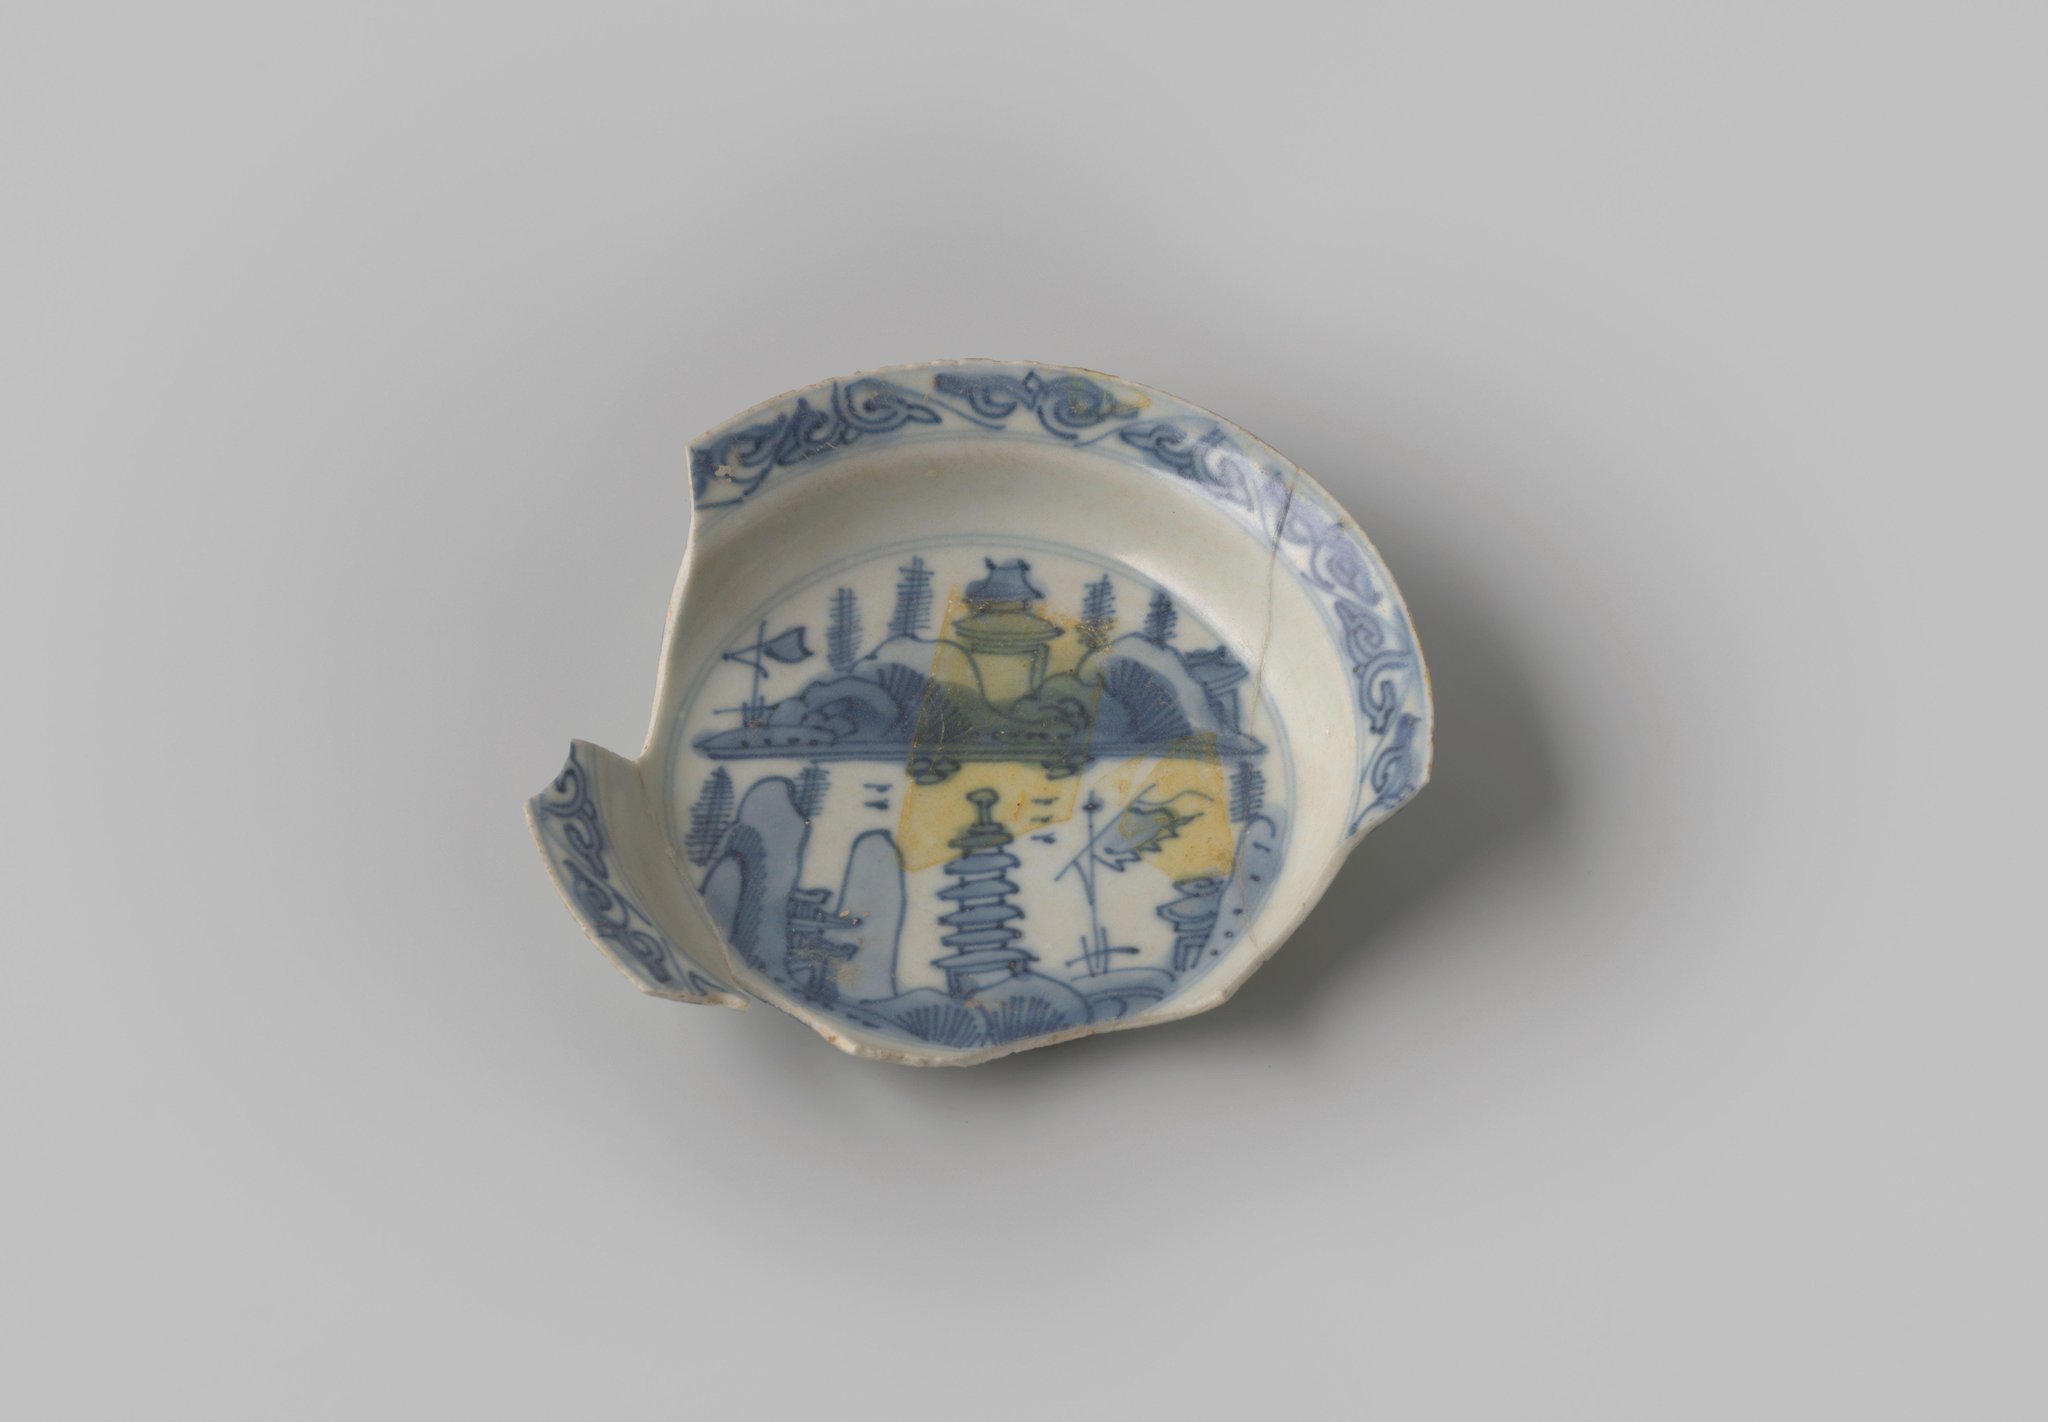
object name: platter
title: Schotel uit V.O.C.-schip de 'Witte Leeuw'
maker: Anonymous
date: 1613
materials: porcelain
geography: jingdezhen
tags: verenigde oostindische compagnie, sint-helena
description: A saucer with a flattened rim. The central decoration consists of a landscape with a tall pagoda and hills. In the background again hills with a small pavillion and a lake. The cavetto is plain and on the flat lip-rim is a scroll of leaves. The outside is decorated with two long sprigs of grass and the lip-rim with three flower-sprays. On the base a neatly drawn circle in underglaze blue is drawn.